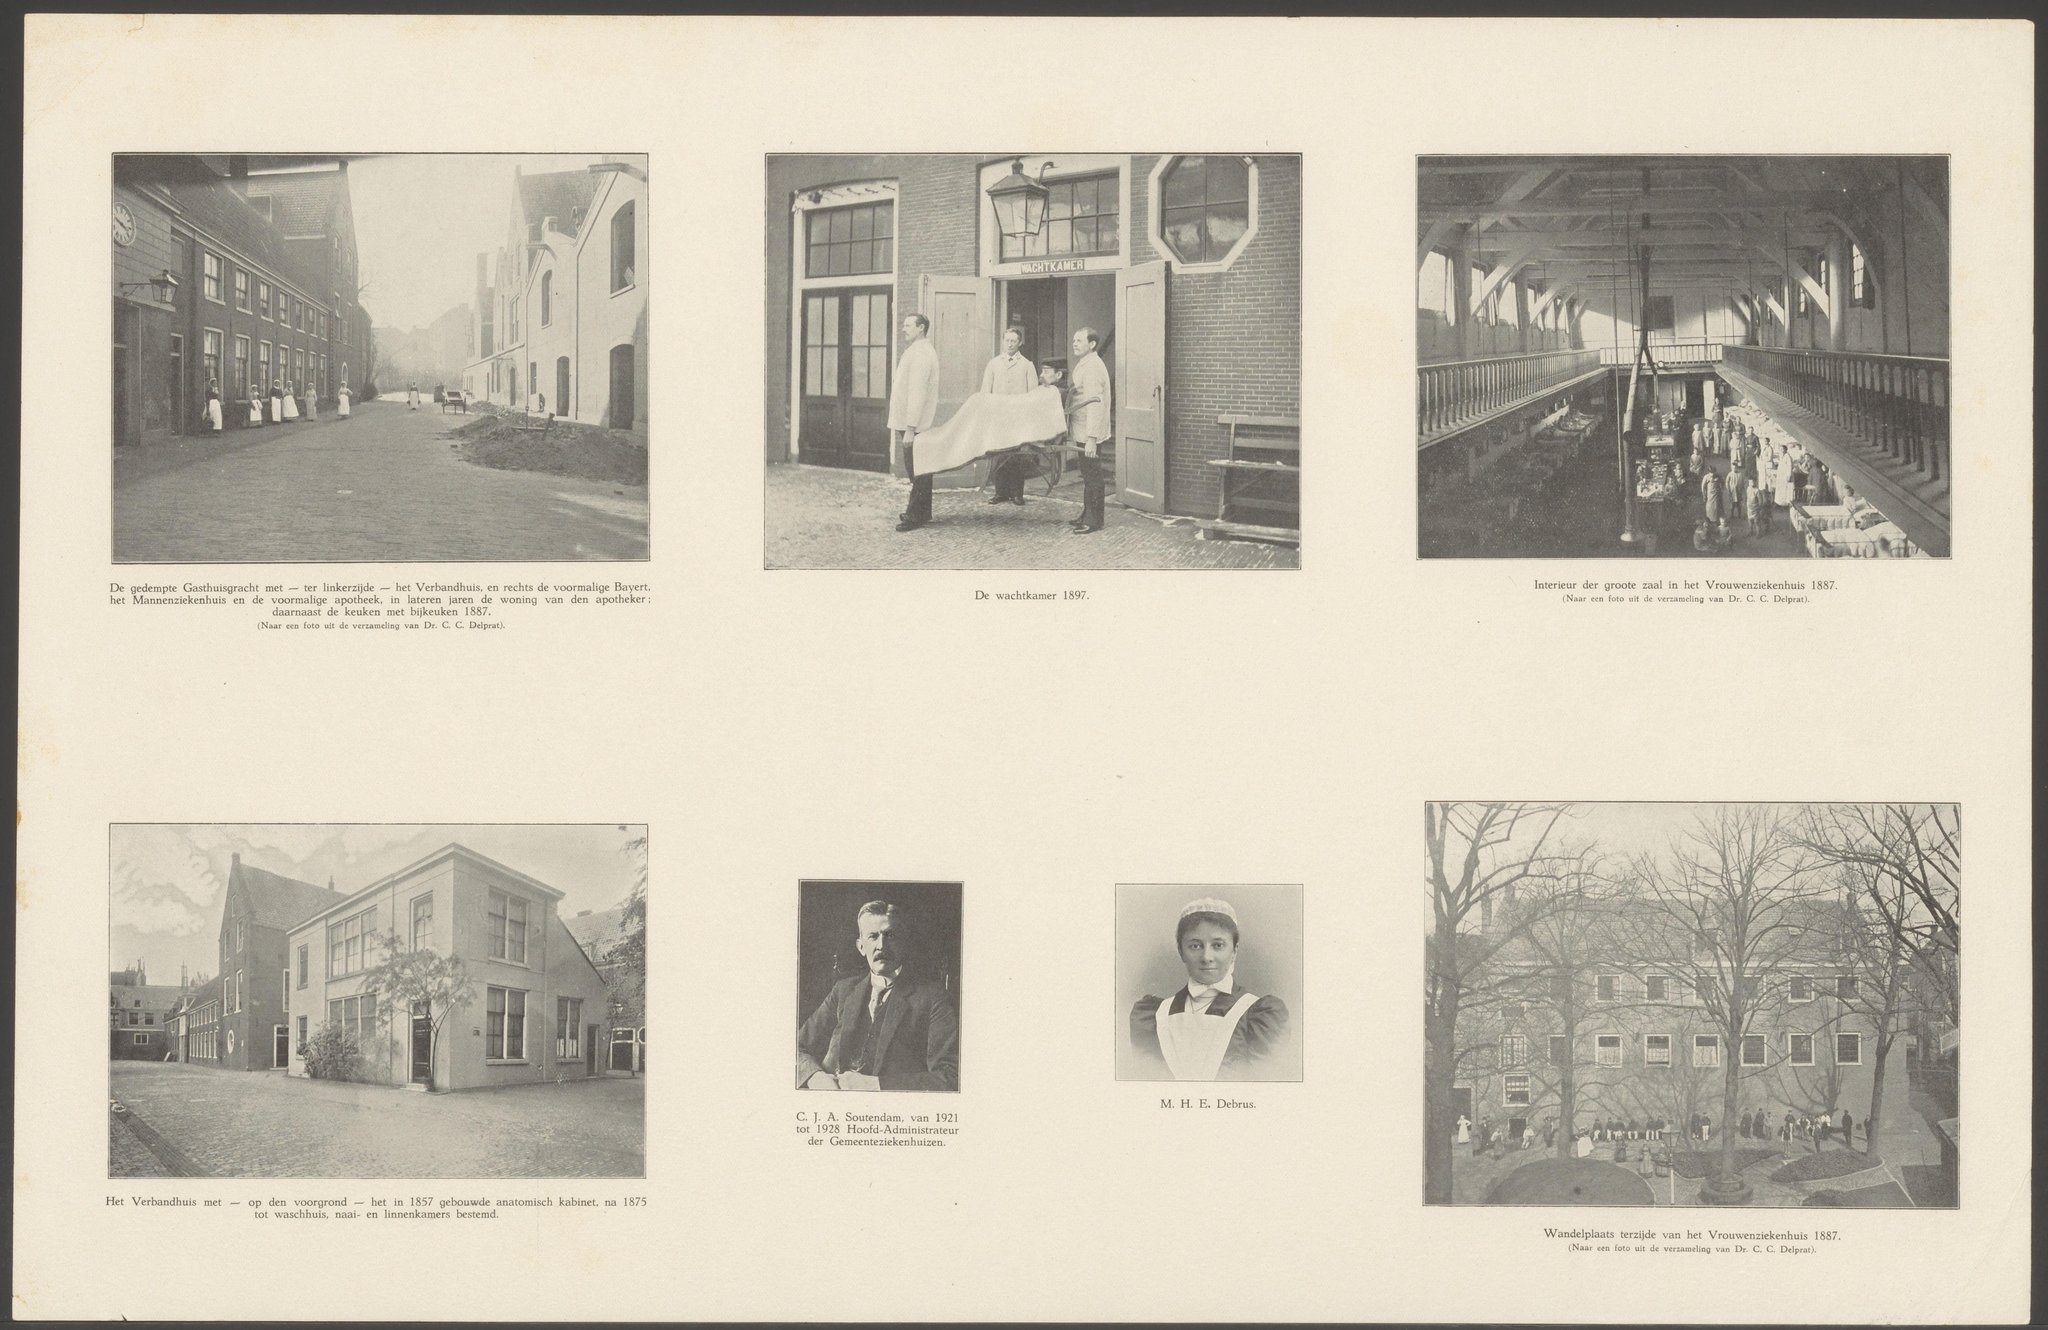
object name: photomechanical print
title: Voorstellingen rond het Binnengasthuis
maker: Anonymous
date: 1912-1970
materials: paper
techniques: letterpress printing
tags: hospital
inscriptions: collector's mark: Lugt 1641b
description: Zeven losse voorstellingen van het Binnengasthuis, met de gedempte Gasthuisgracht, de wachtkamer, de grote zaal, het verbandhuis en de wandelplaats. Onderaan portretten van C.J.A. Soutendam en M.H.E. Debrus. Onderwerpsrubriek binnen de Atlas Amsterdam: Armwezen en liefdadige instellingen: I. Stadsinrichtingen: Binnengasthuis.